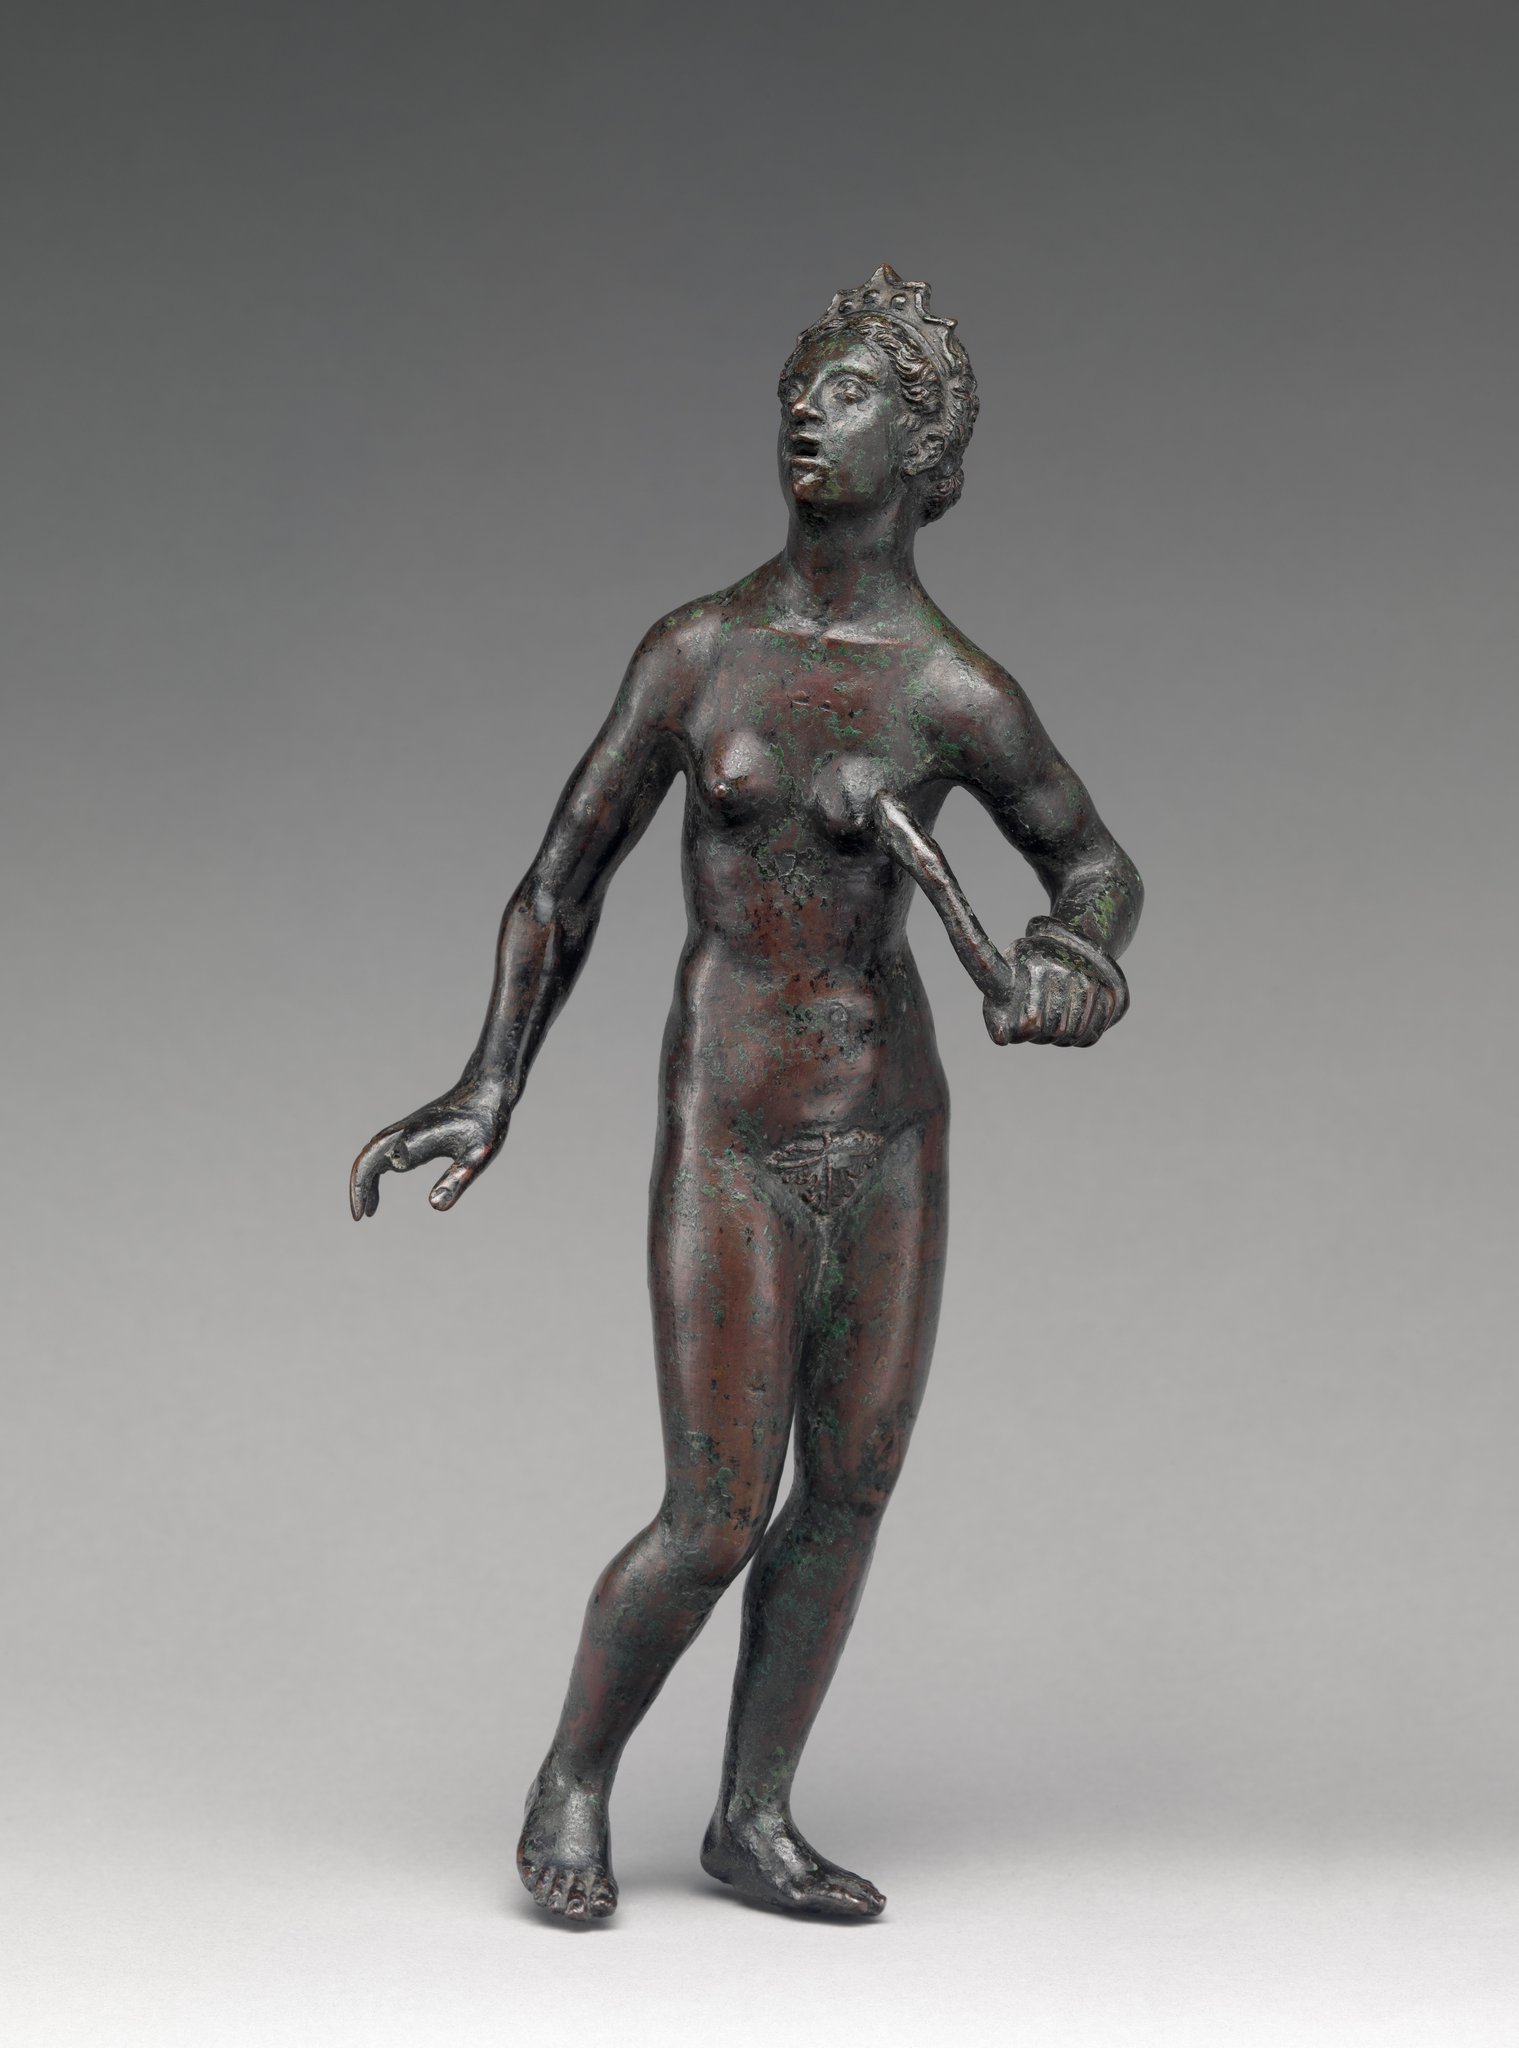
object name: statuette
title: Cleopatra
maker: severo calzetta da ravenna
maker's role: artist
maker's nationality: italian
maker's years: 1496-1543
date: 1534-1566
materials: bronze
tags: female nudes